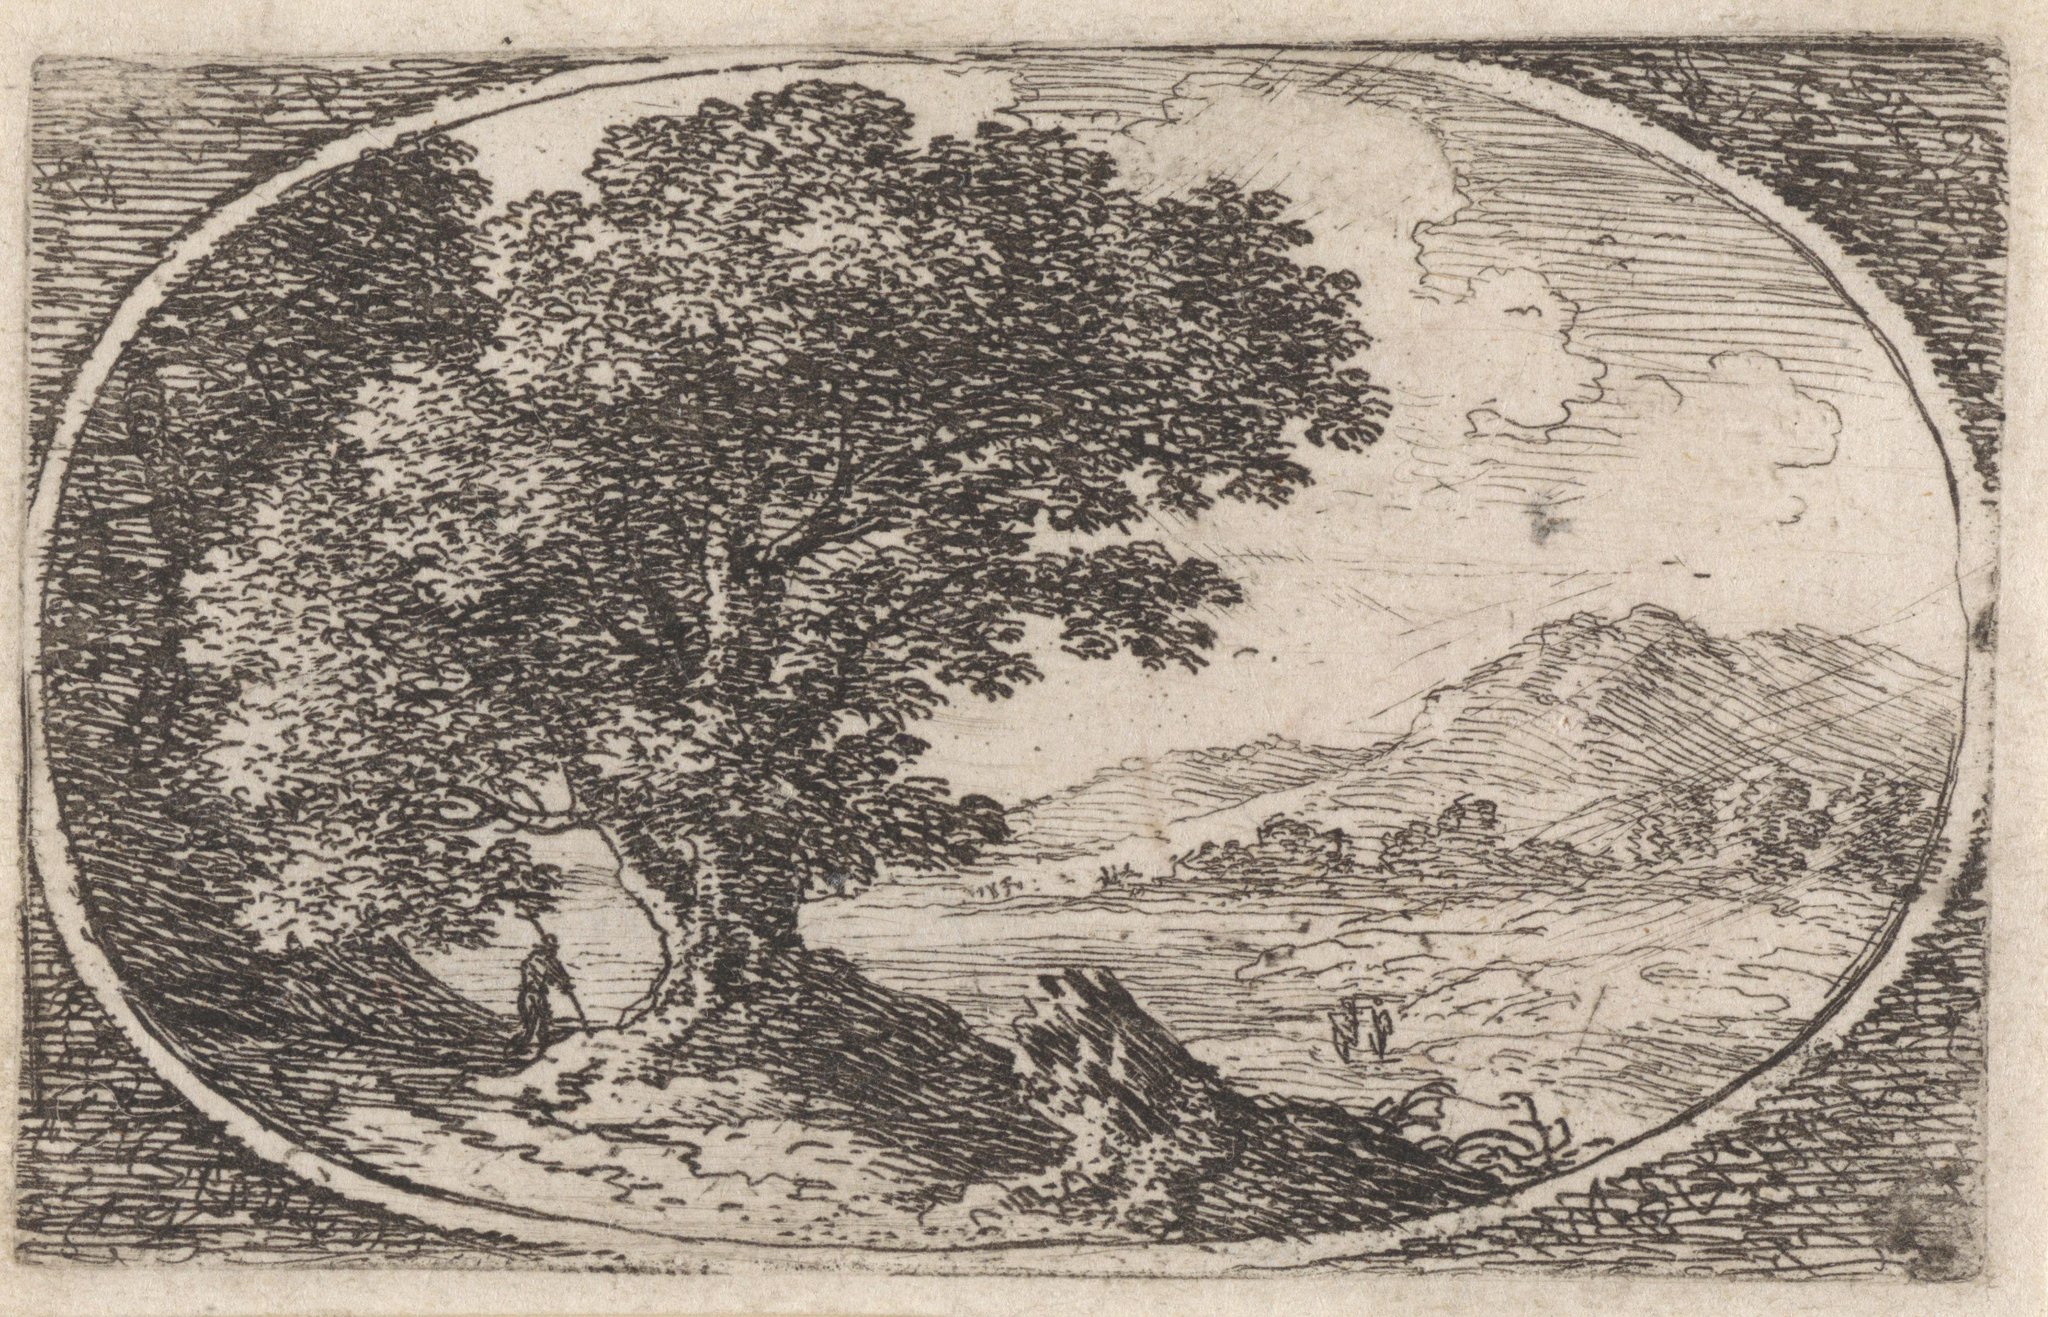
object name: print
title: Ovale fantasielandschappen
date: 1650-1655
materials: paper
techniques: etching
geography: paris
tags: landscapes, (high) hill, 'en route', traveller under way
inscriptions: collector's mark: Lugt 240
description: In een ovale omlijsting loopt een wandelaar op een pad bij een boom. Vooraan is een boomstronk te zien. In de verte liggen enkele heuvels.